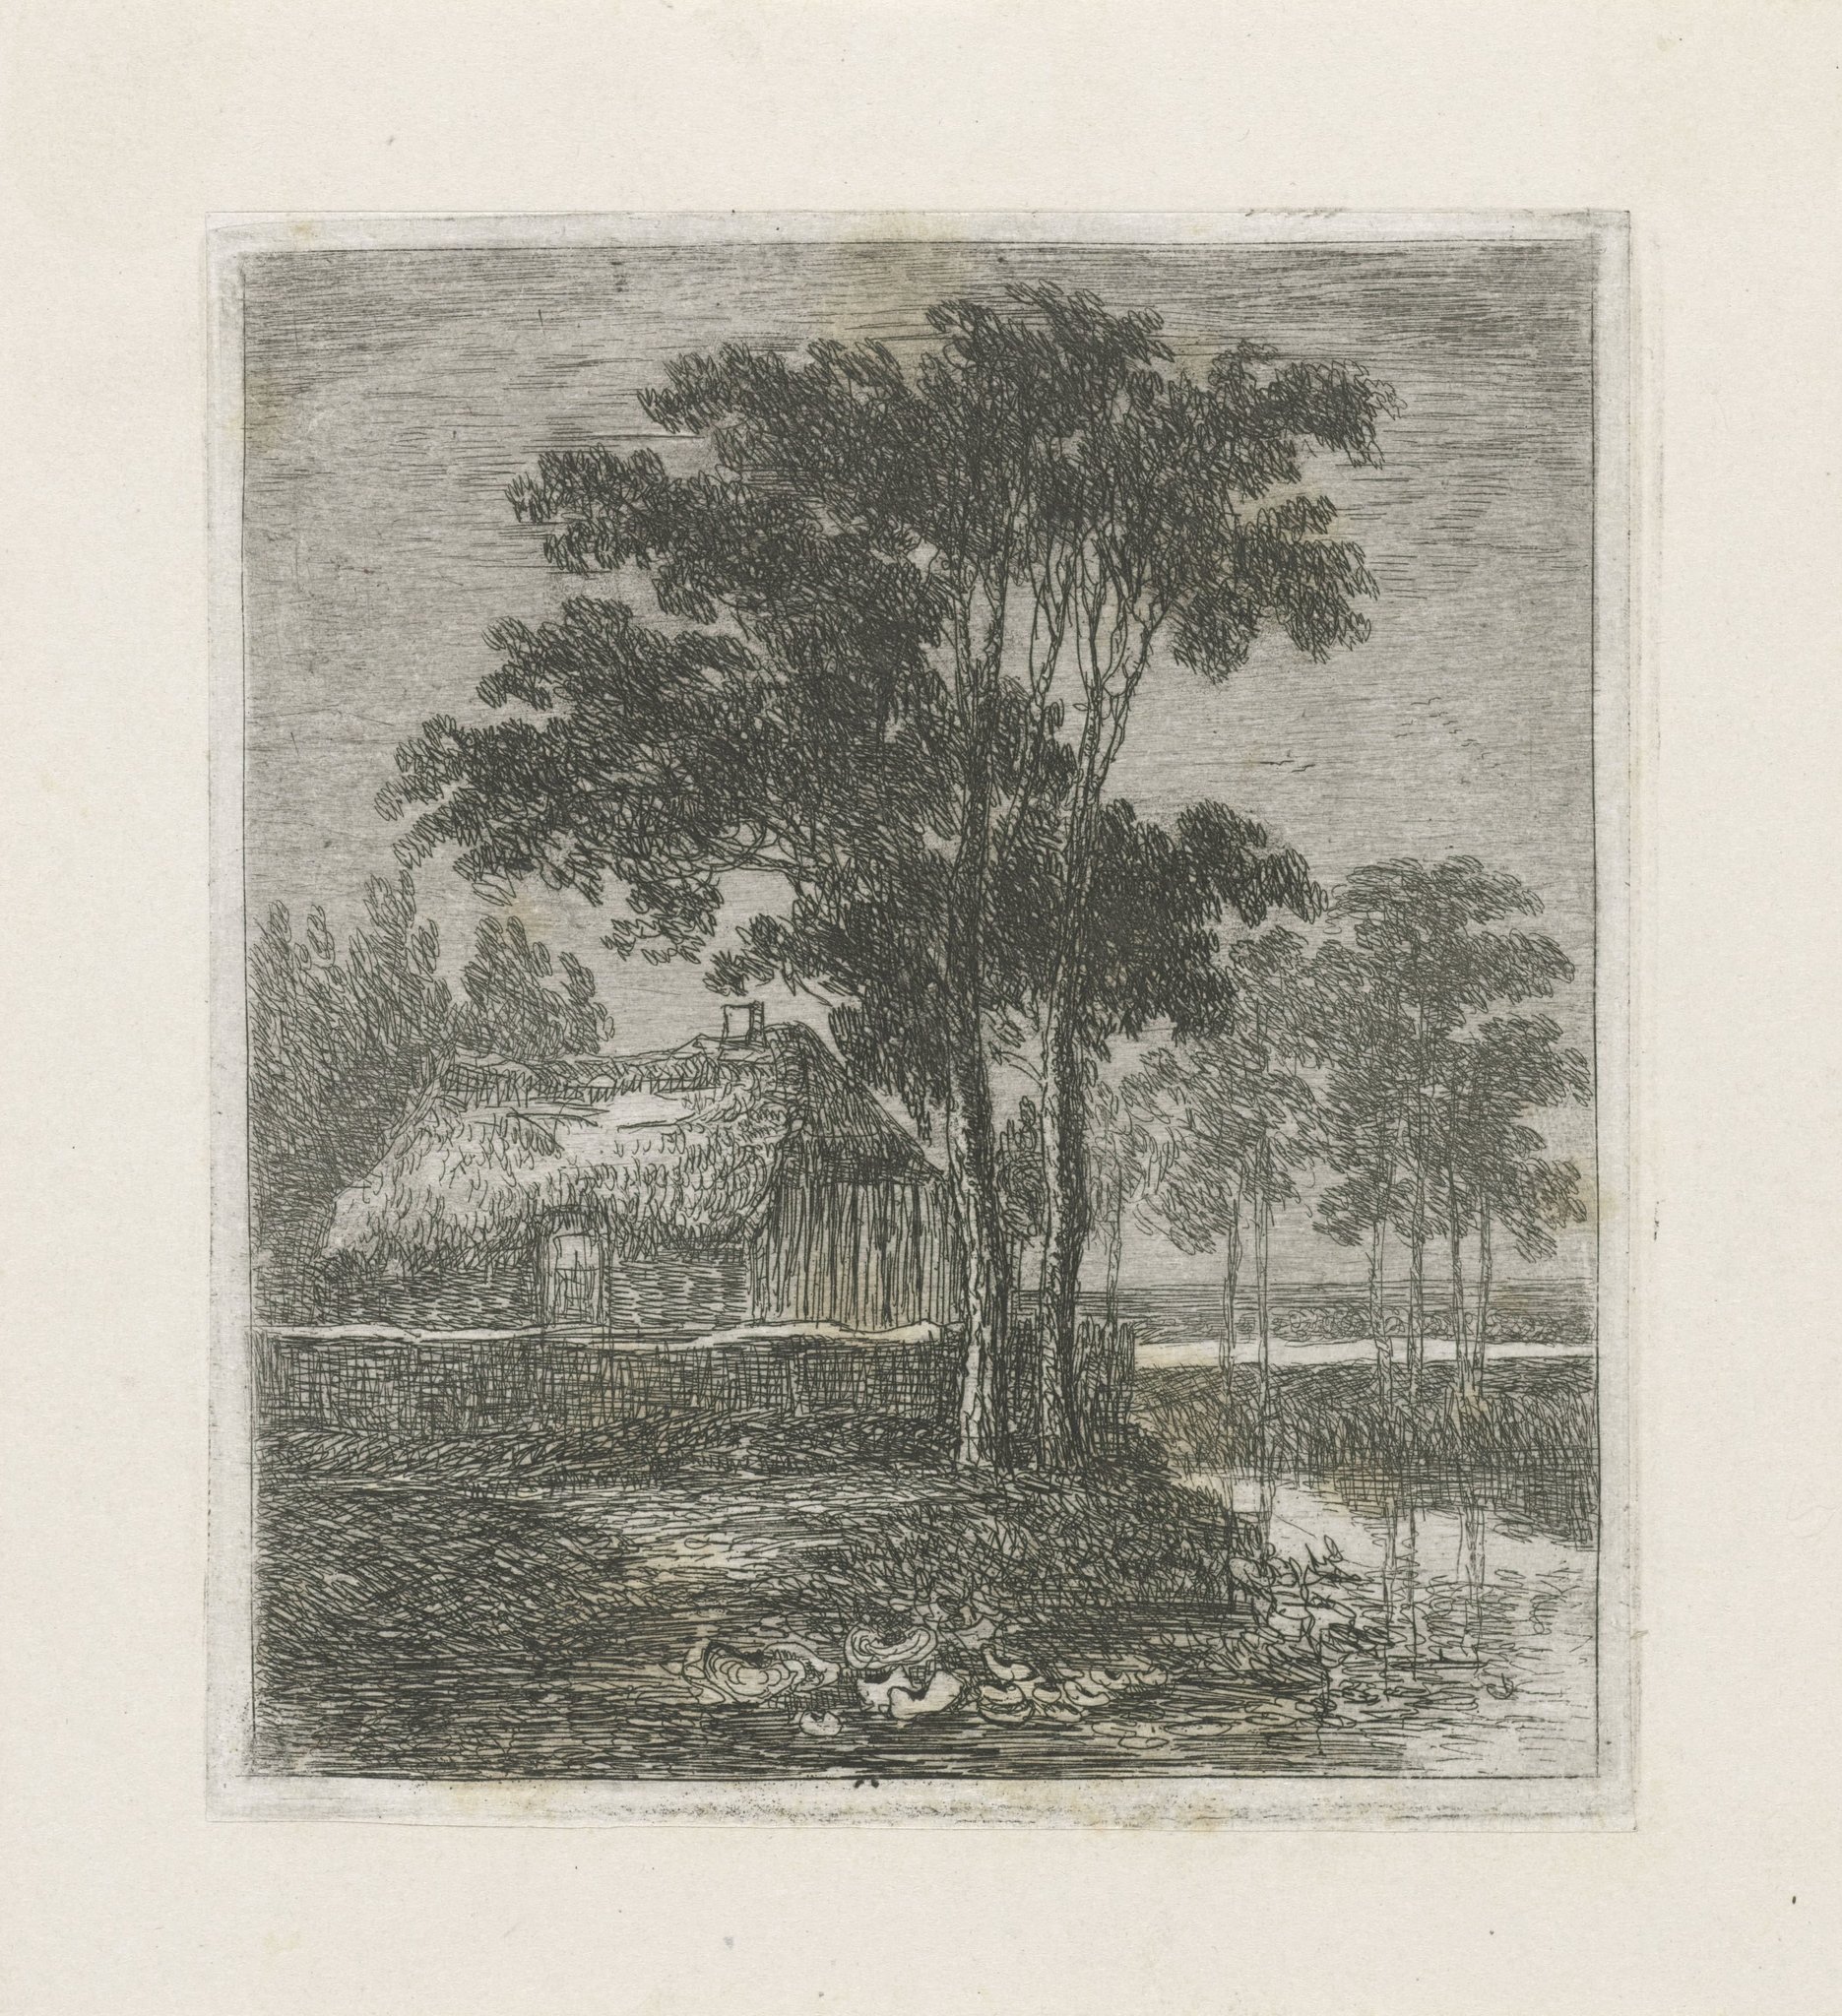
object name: print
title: Boerenhoeve en bomen aan een waterkant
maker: hermanus jan hendrik van rijkelijkhuysen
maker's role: painter, print maker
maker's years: 1813-1883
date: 1823-1883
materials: paper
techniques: drypoint, etching, intaglio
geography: utrecht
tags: trees, pool, puddle, farm or solitary house in landscape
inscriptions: collector's mark: Lugt 1485, collector's mark: Lugt 2228